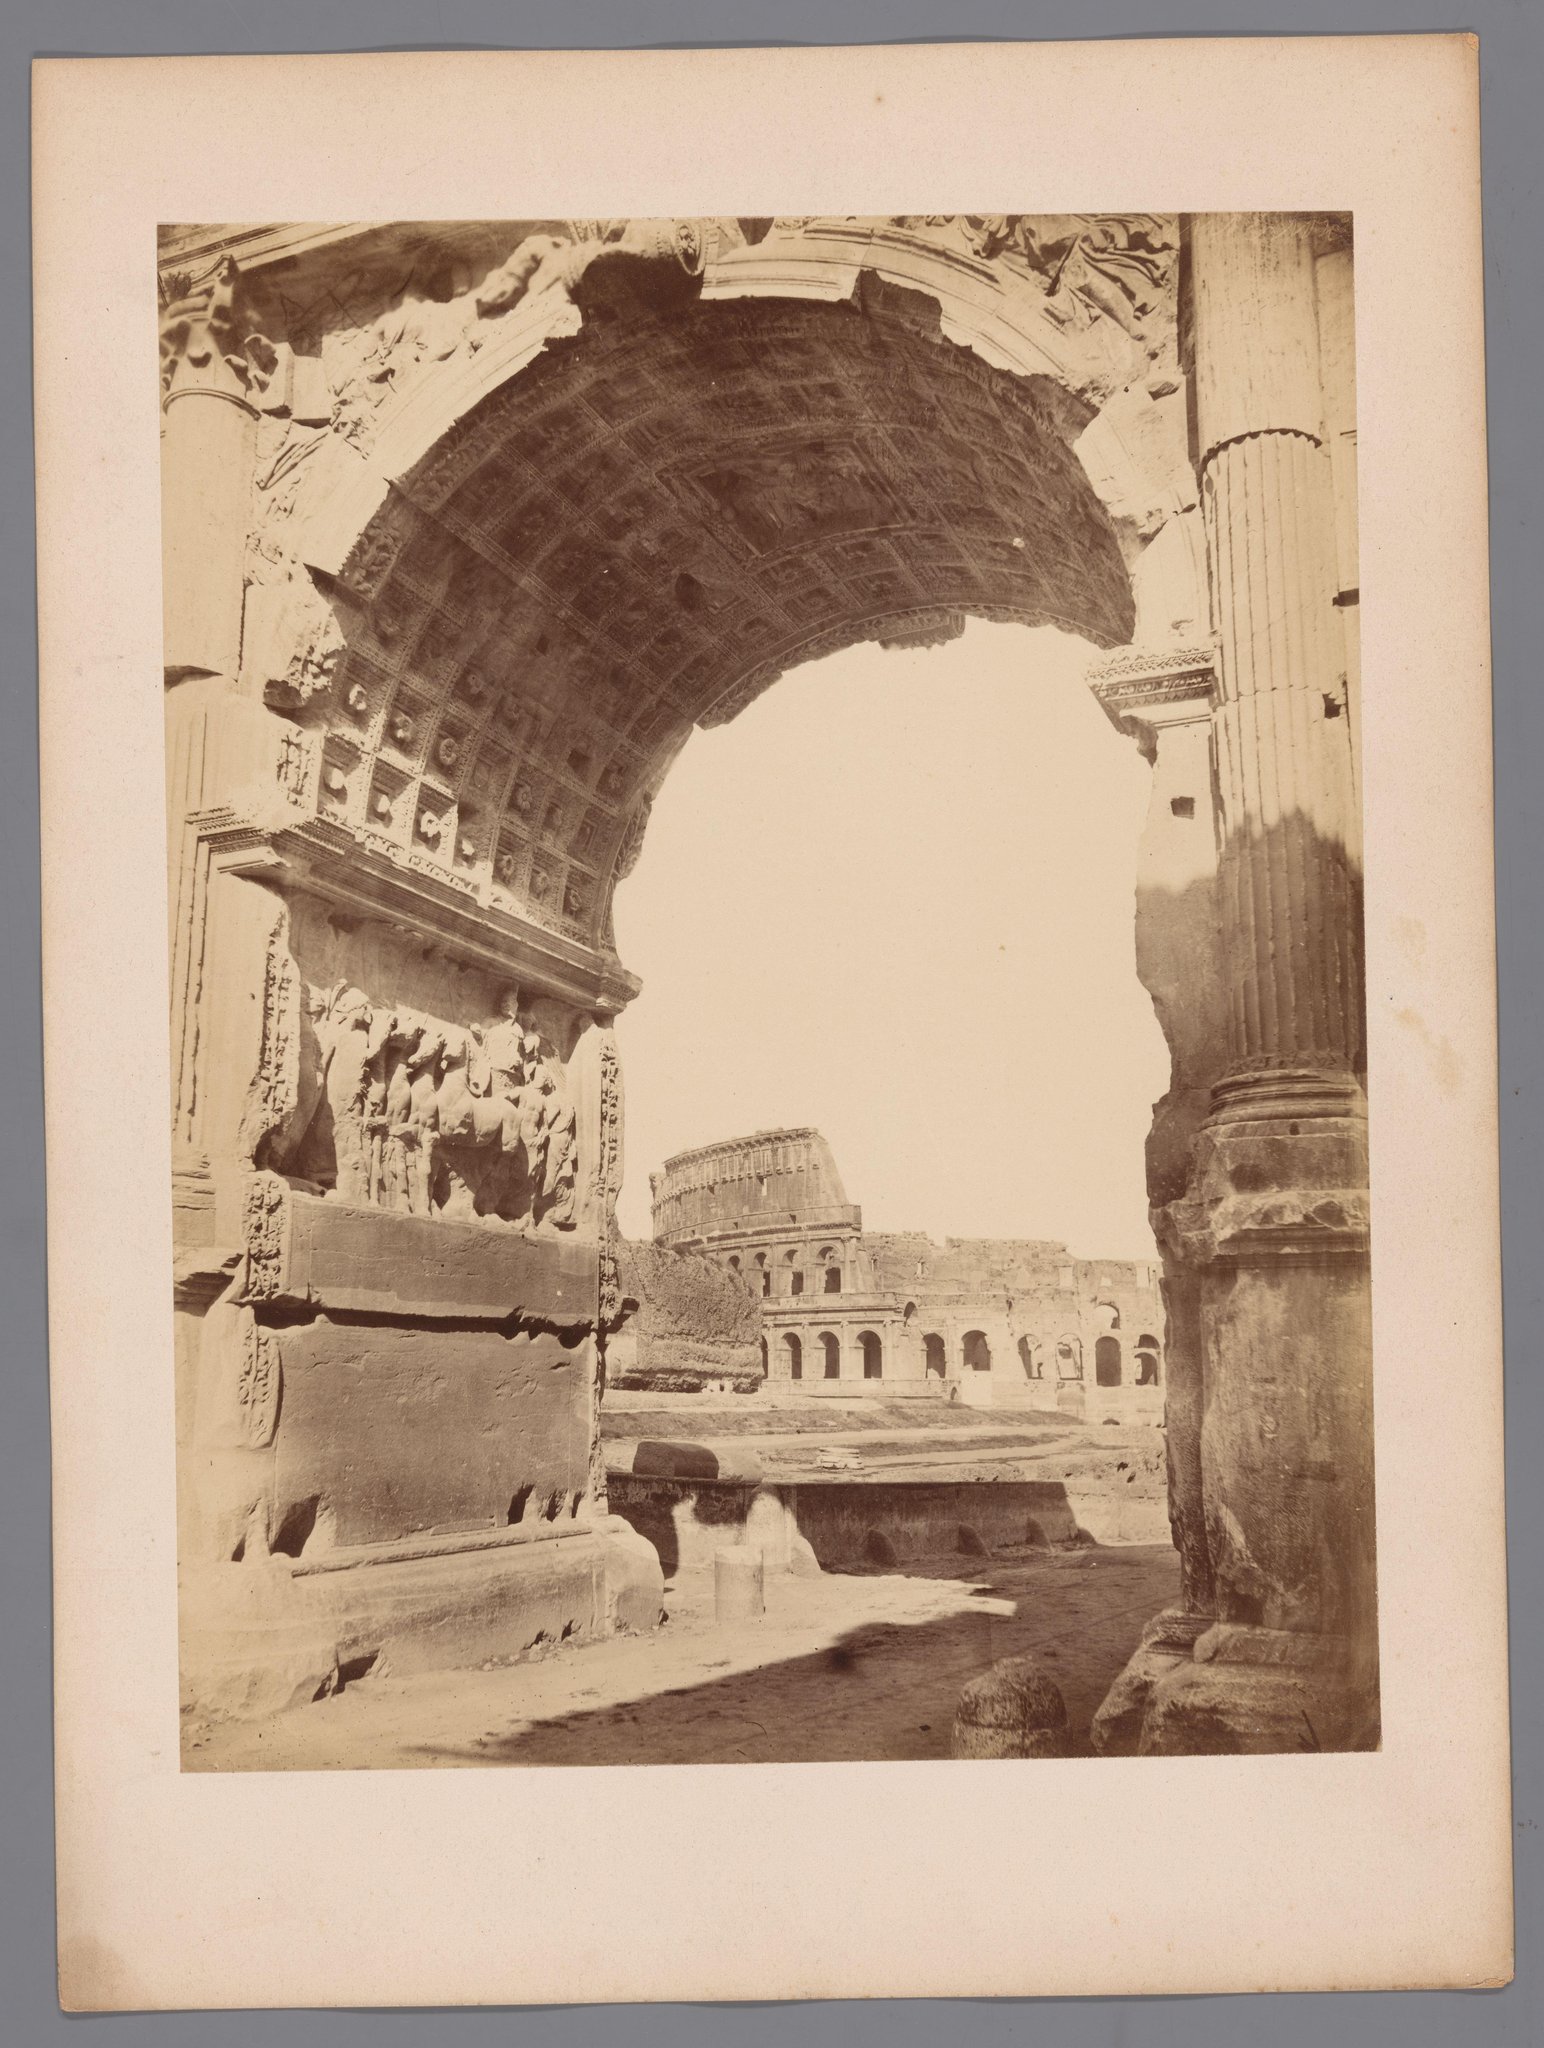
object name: photograph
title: Colosseum gezien door de Boog van Titus te Rome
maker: Anonymous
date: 1851-1900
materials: cardboard, paper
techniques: albumen print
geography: rome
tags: ruin of a building ~ architecture, triumphal arch